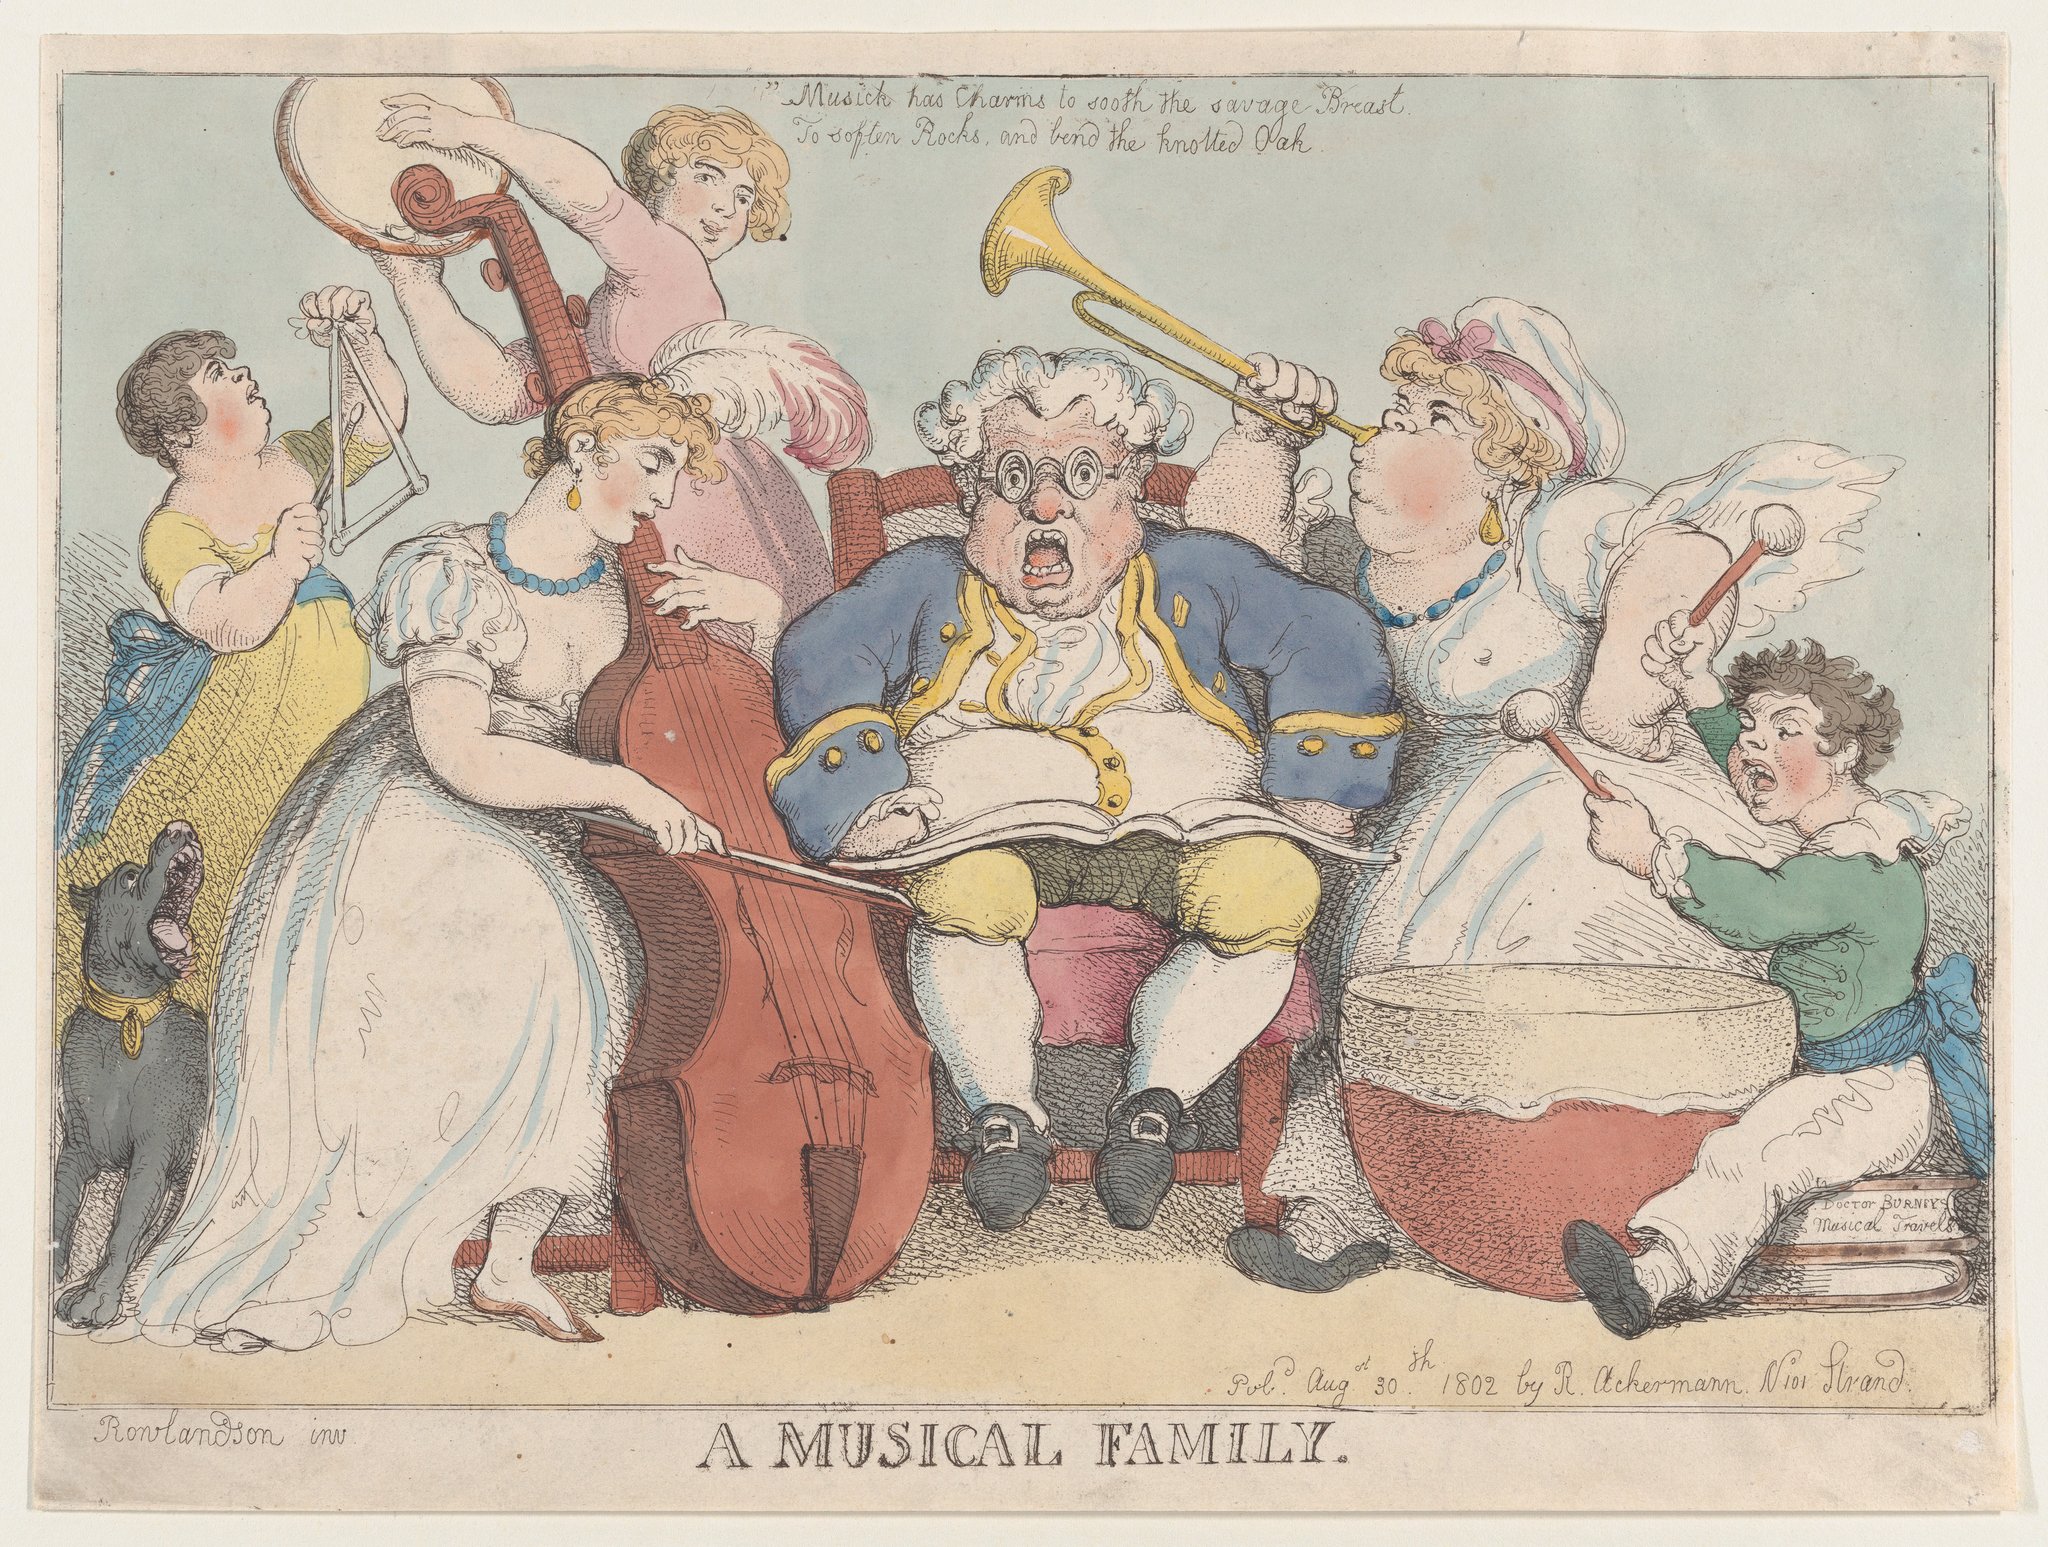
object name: print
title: A Musical Family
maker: thomas rowlandson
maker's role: artist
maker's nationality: british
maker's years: 1757-1827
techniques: etching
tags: men,women,cellos,drums,flutes